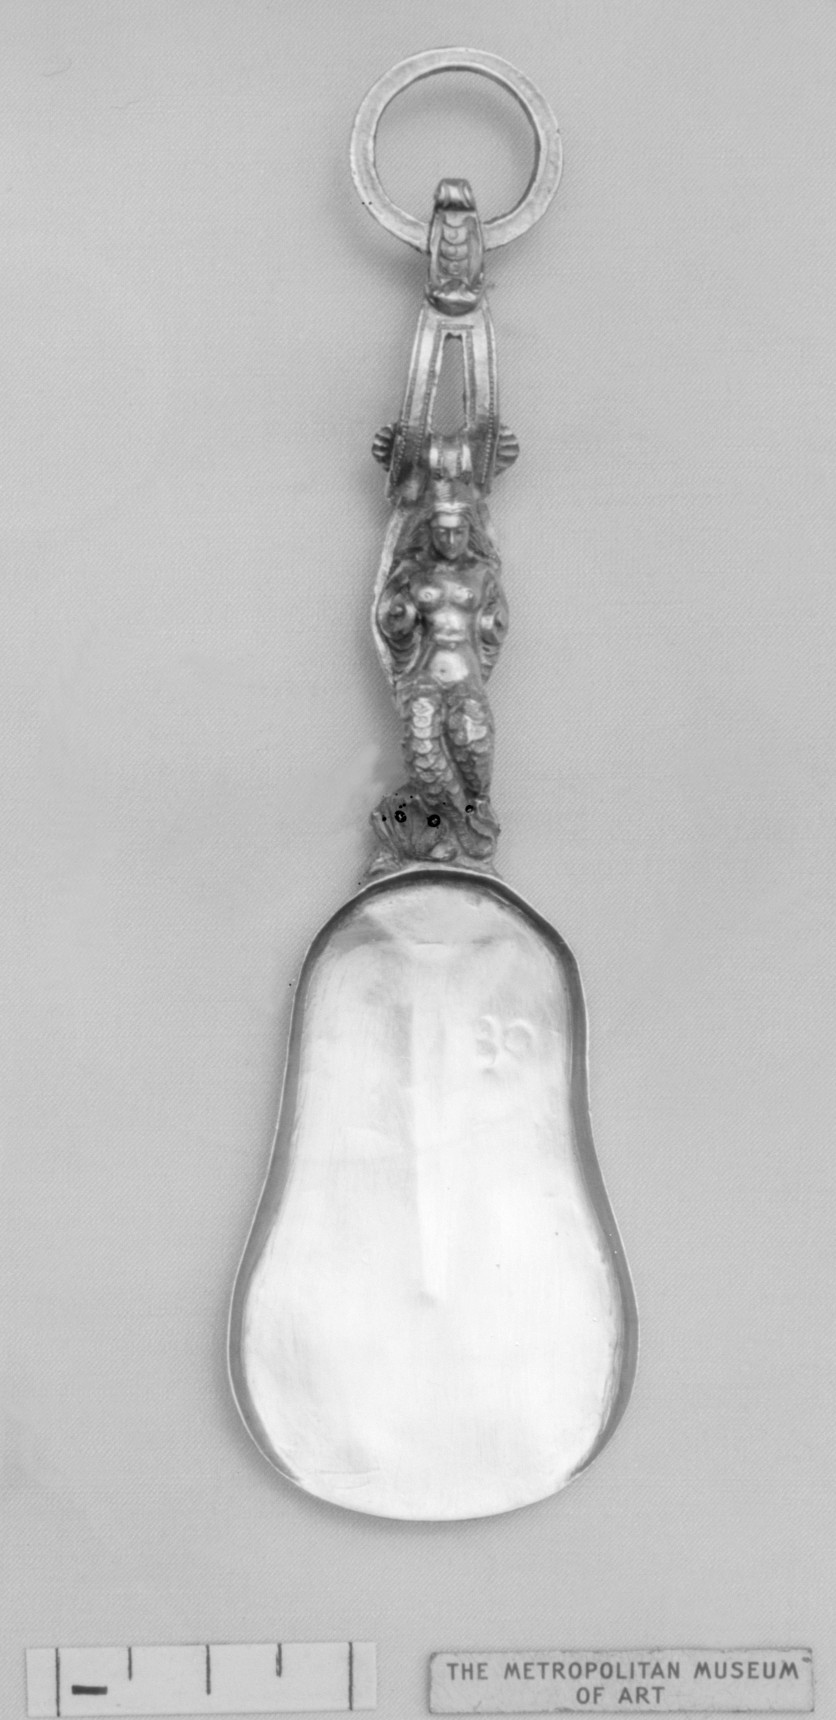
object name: spoon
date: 1676-1700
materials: gilt, silver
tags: mermaids